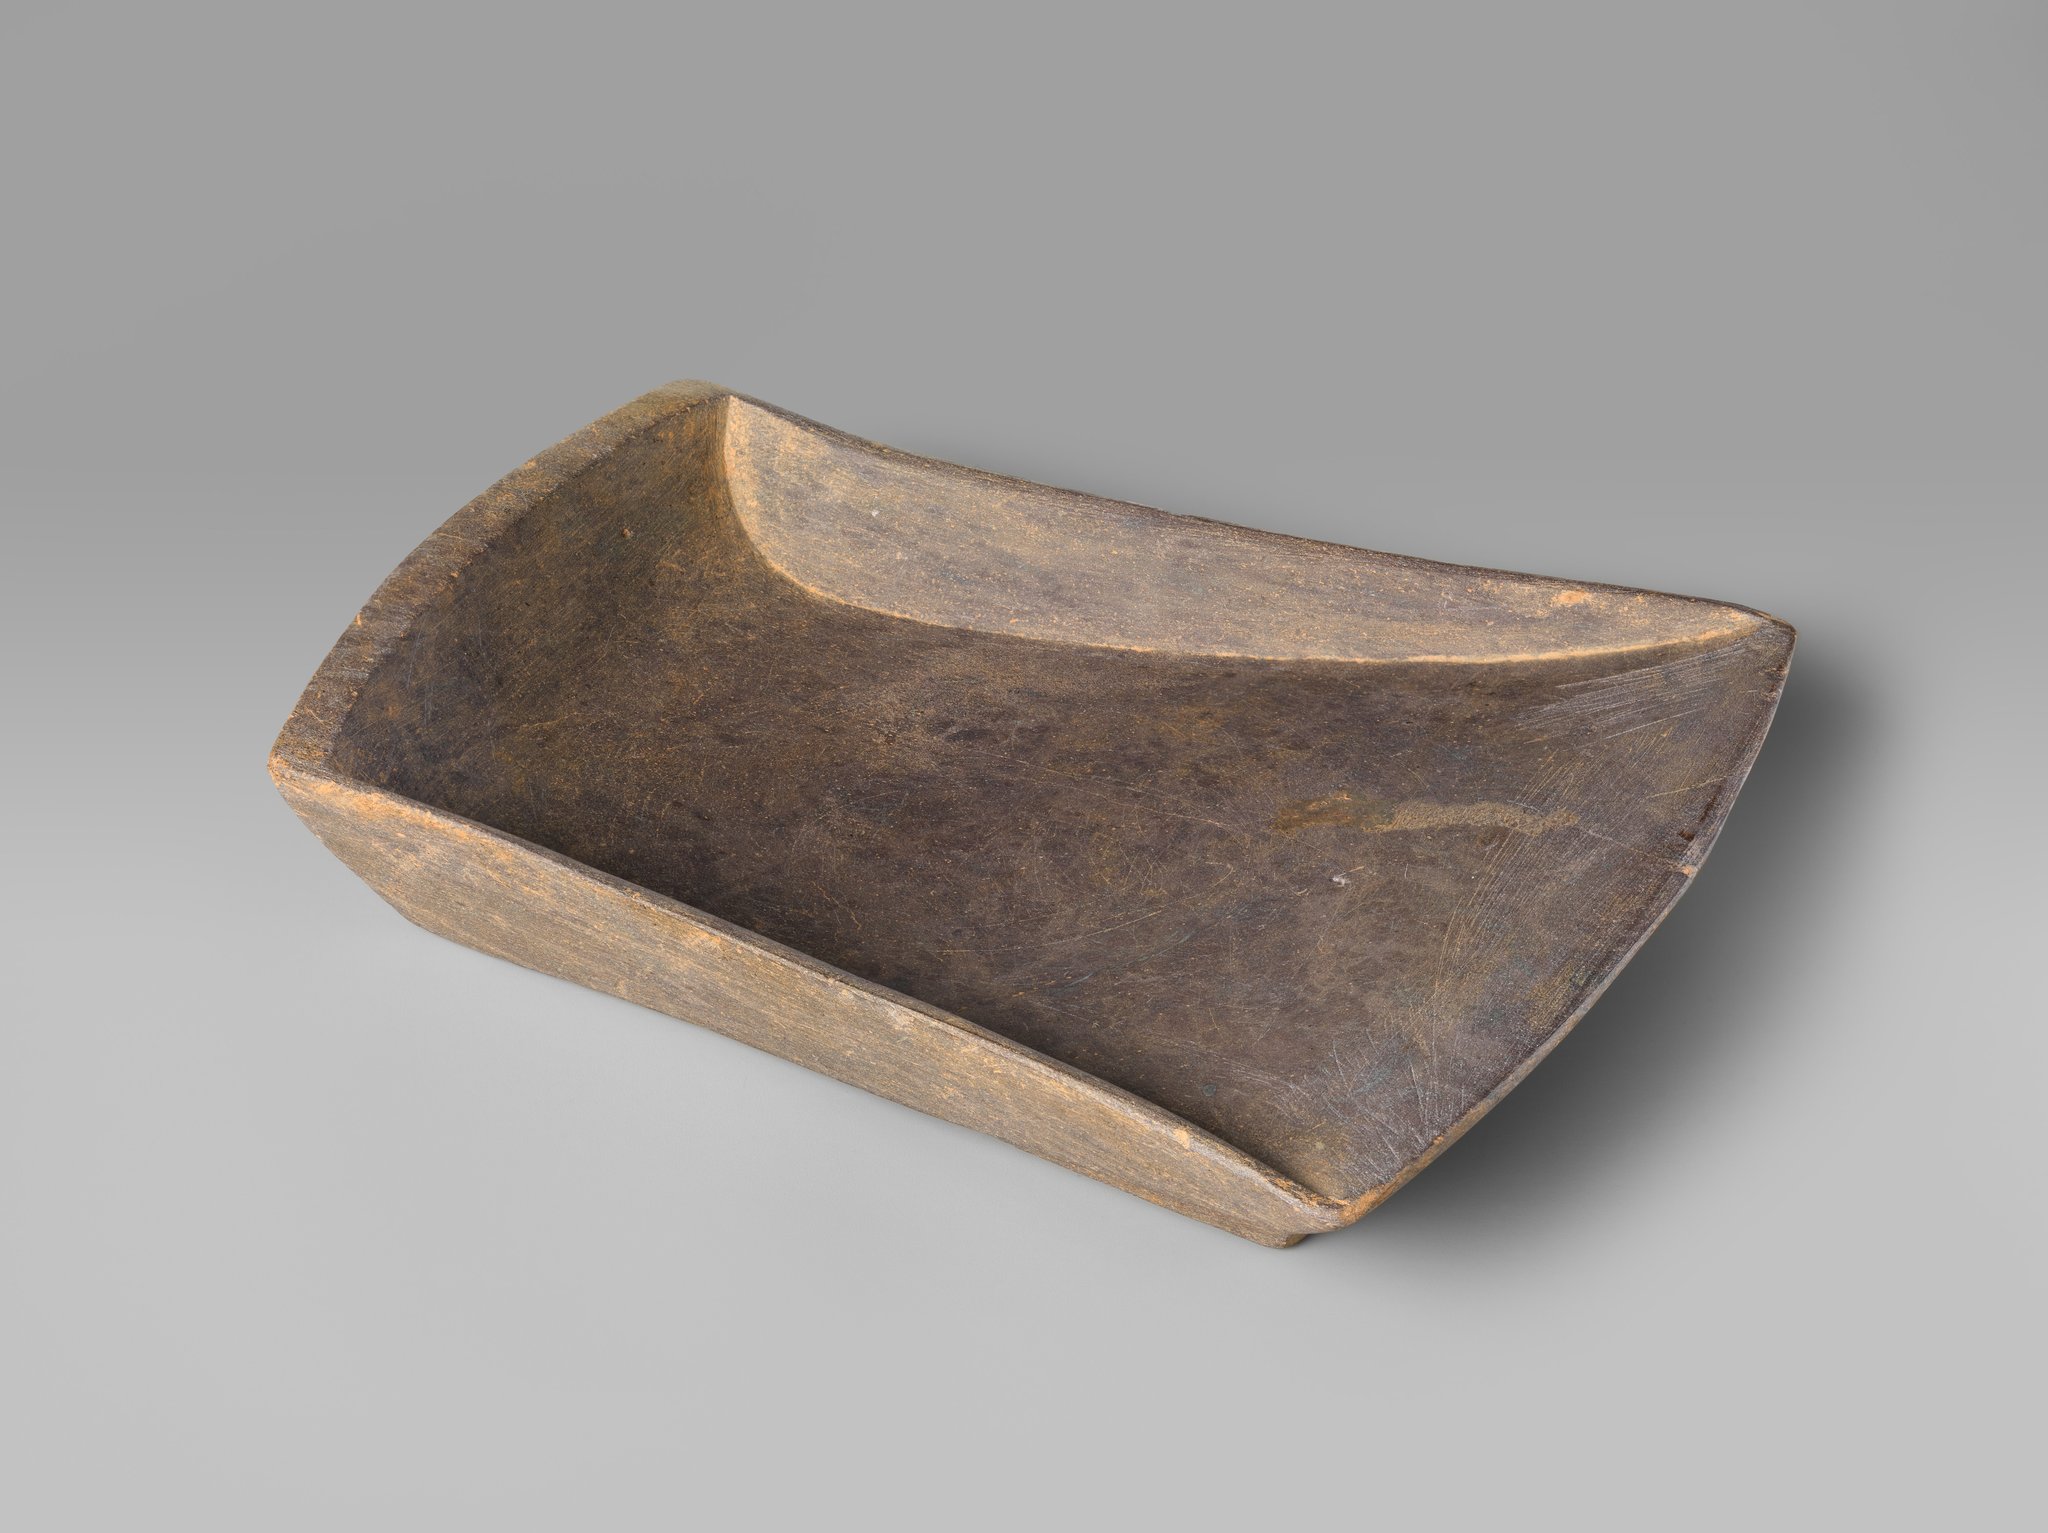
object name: inkstone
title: Inkstone in the Shape of the Chinese Character "Wind" (Feng)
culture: chinese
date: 960-1279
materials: stone